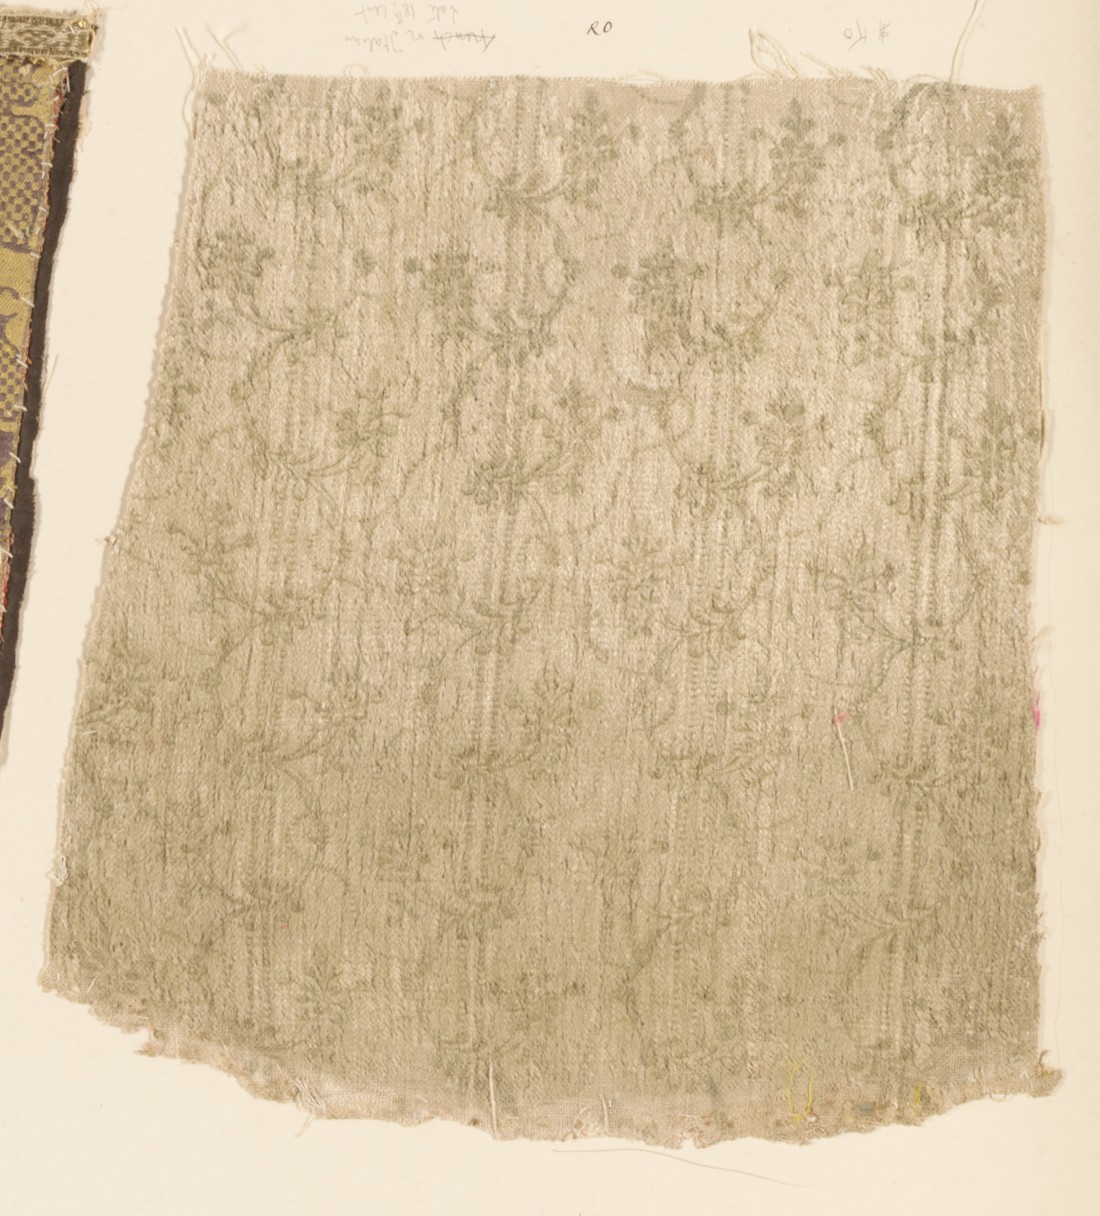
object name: fragment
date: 1767-1800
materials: silk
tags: flowers